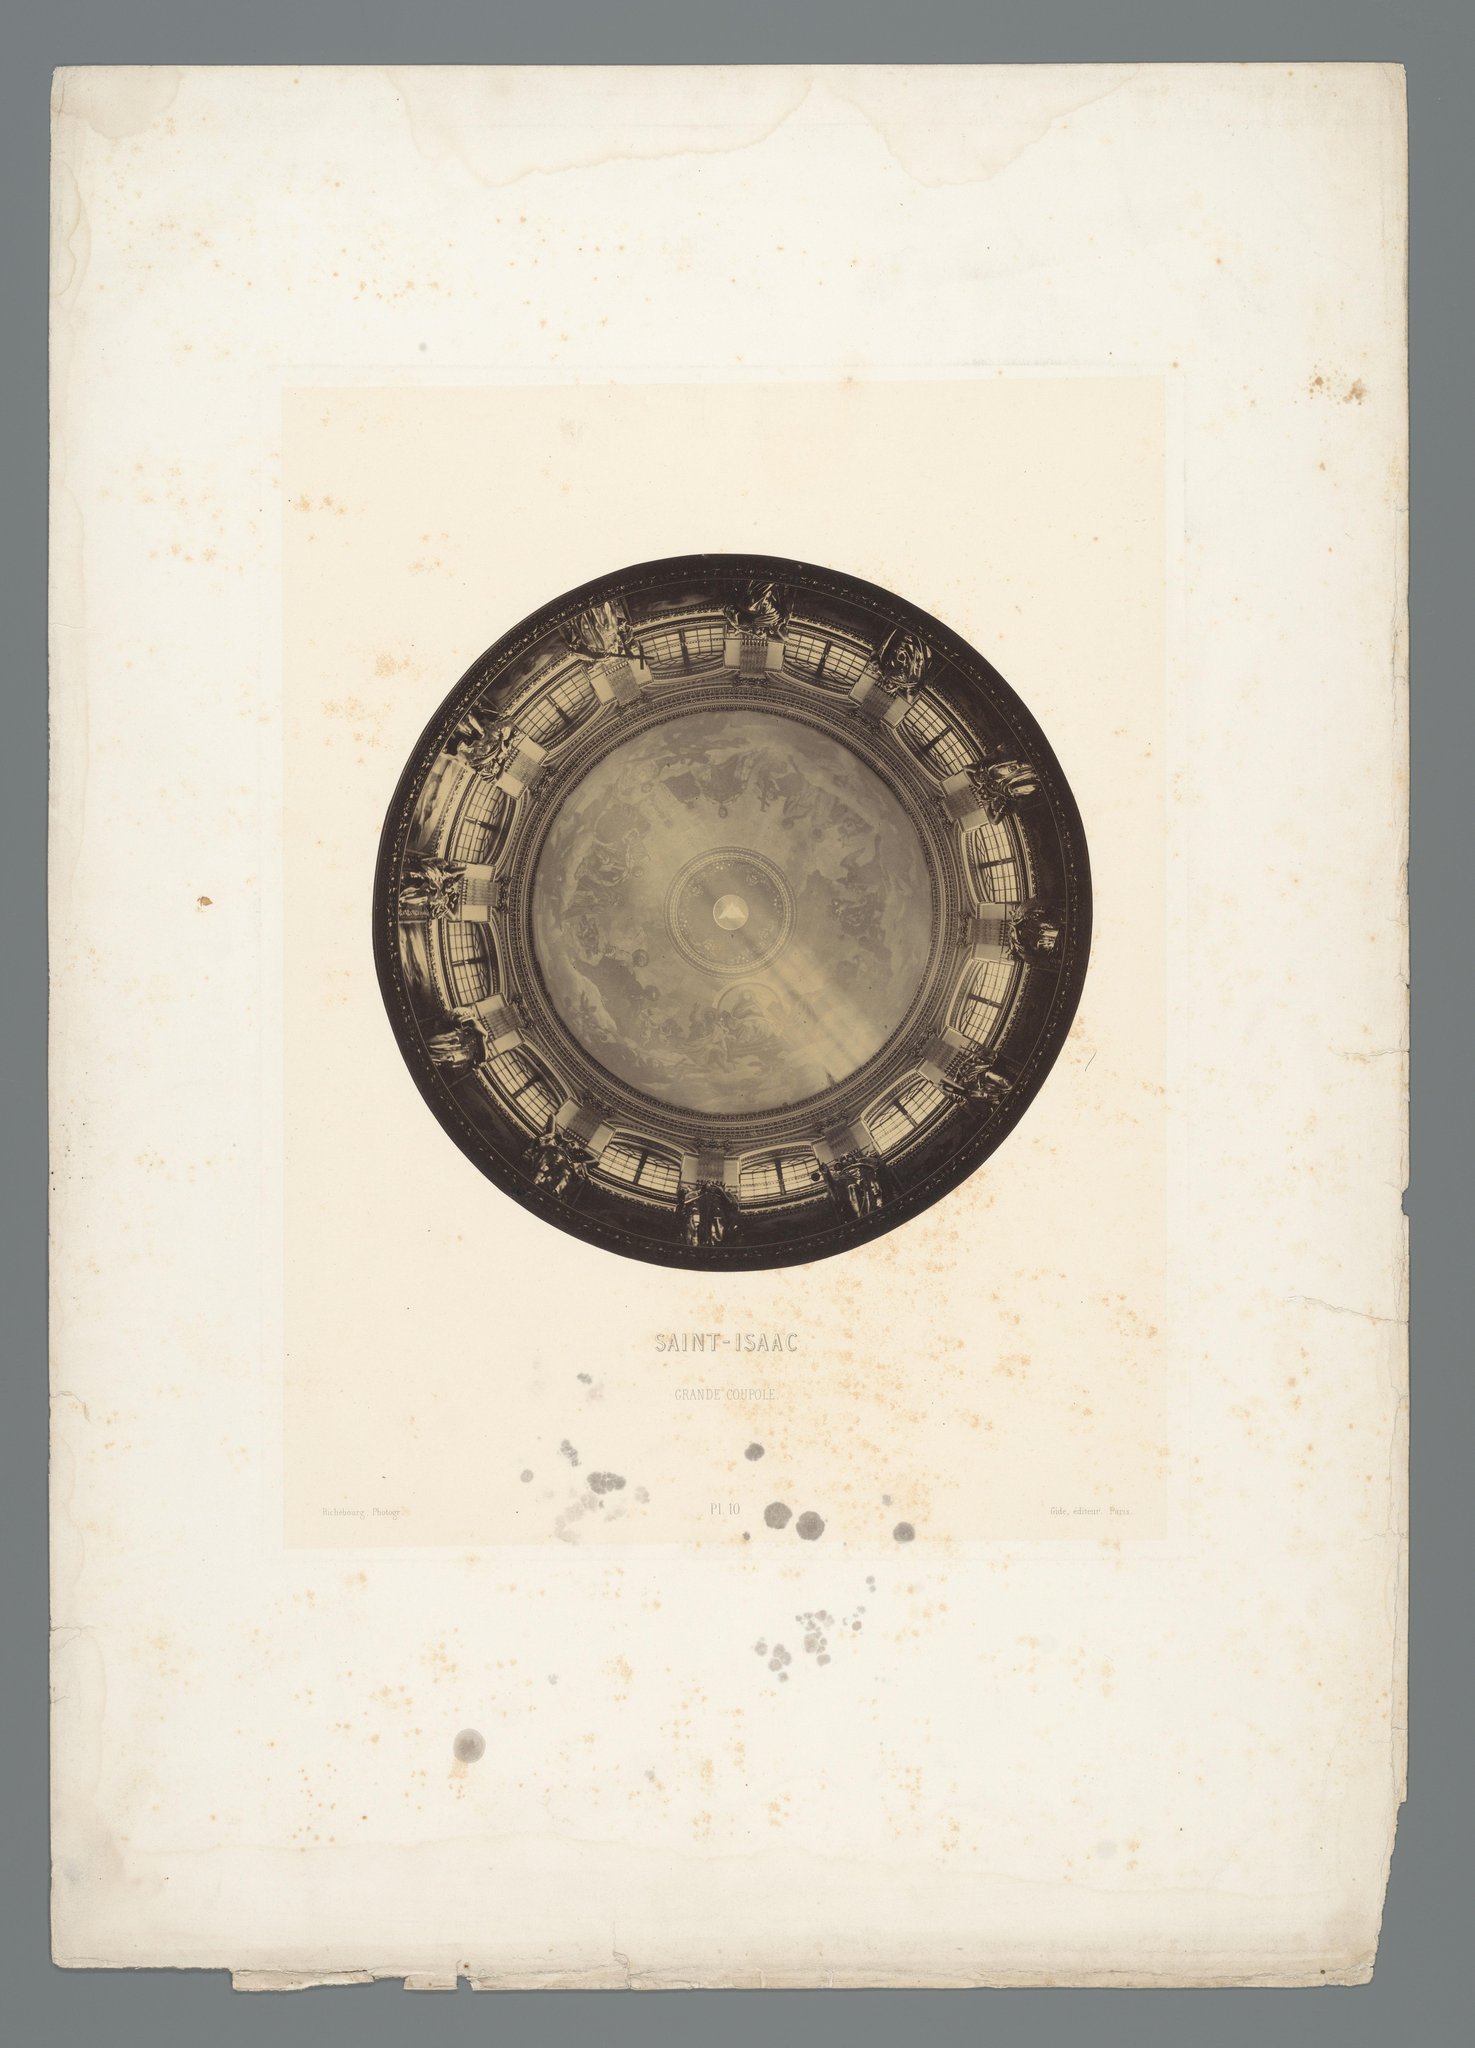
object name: photograph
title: Koepel van de Izaäkkathedraal in Sint-Petersburg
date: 1859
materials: cardboard, paper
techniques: albumen print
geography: paris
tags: parts of church interior: dome